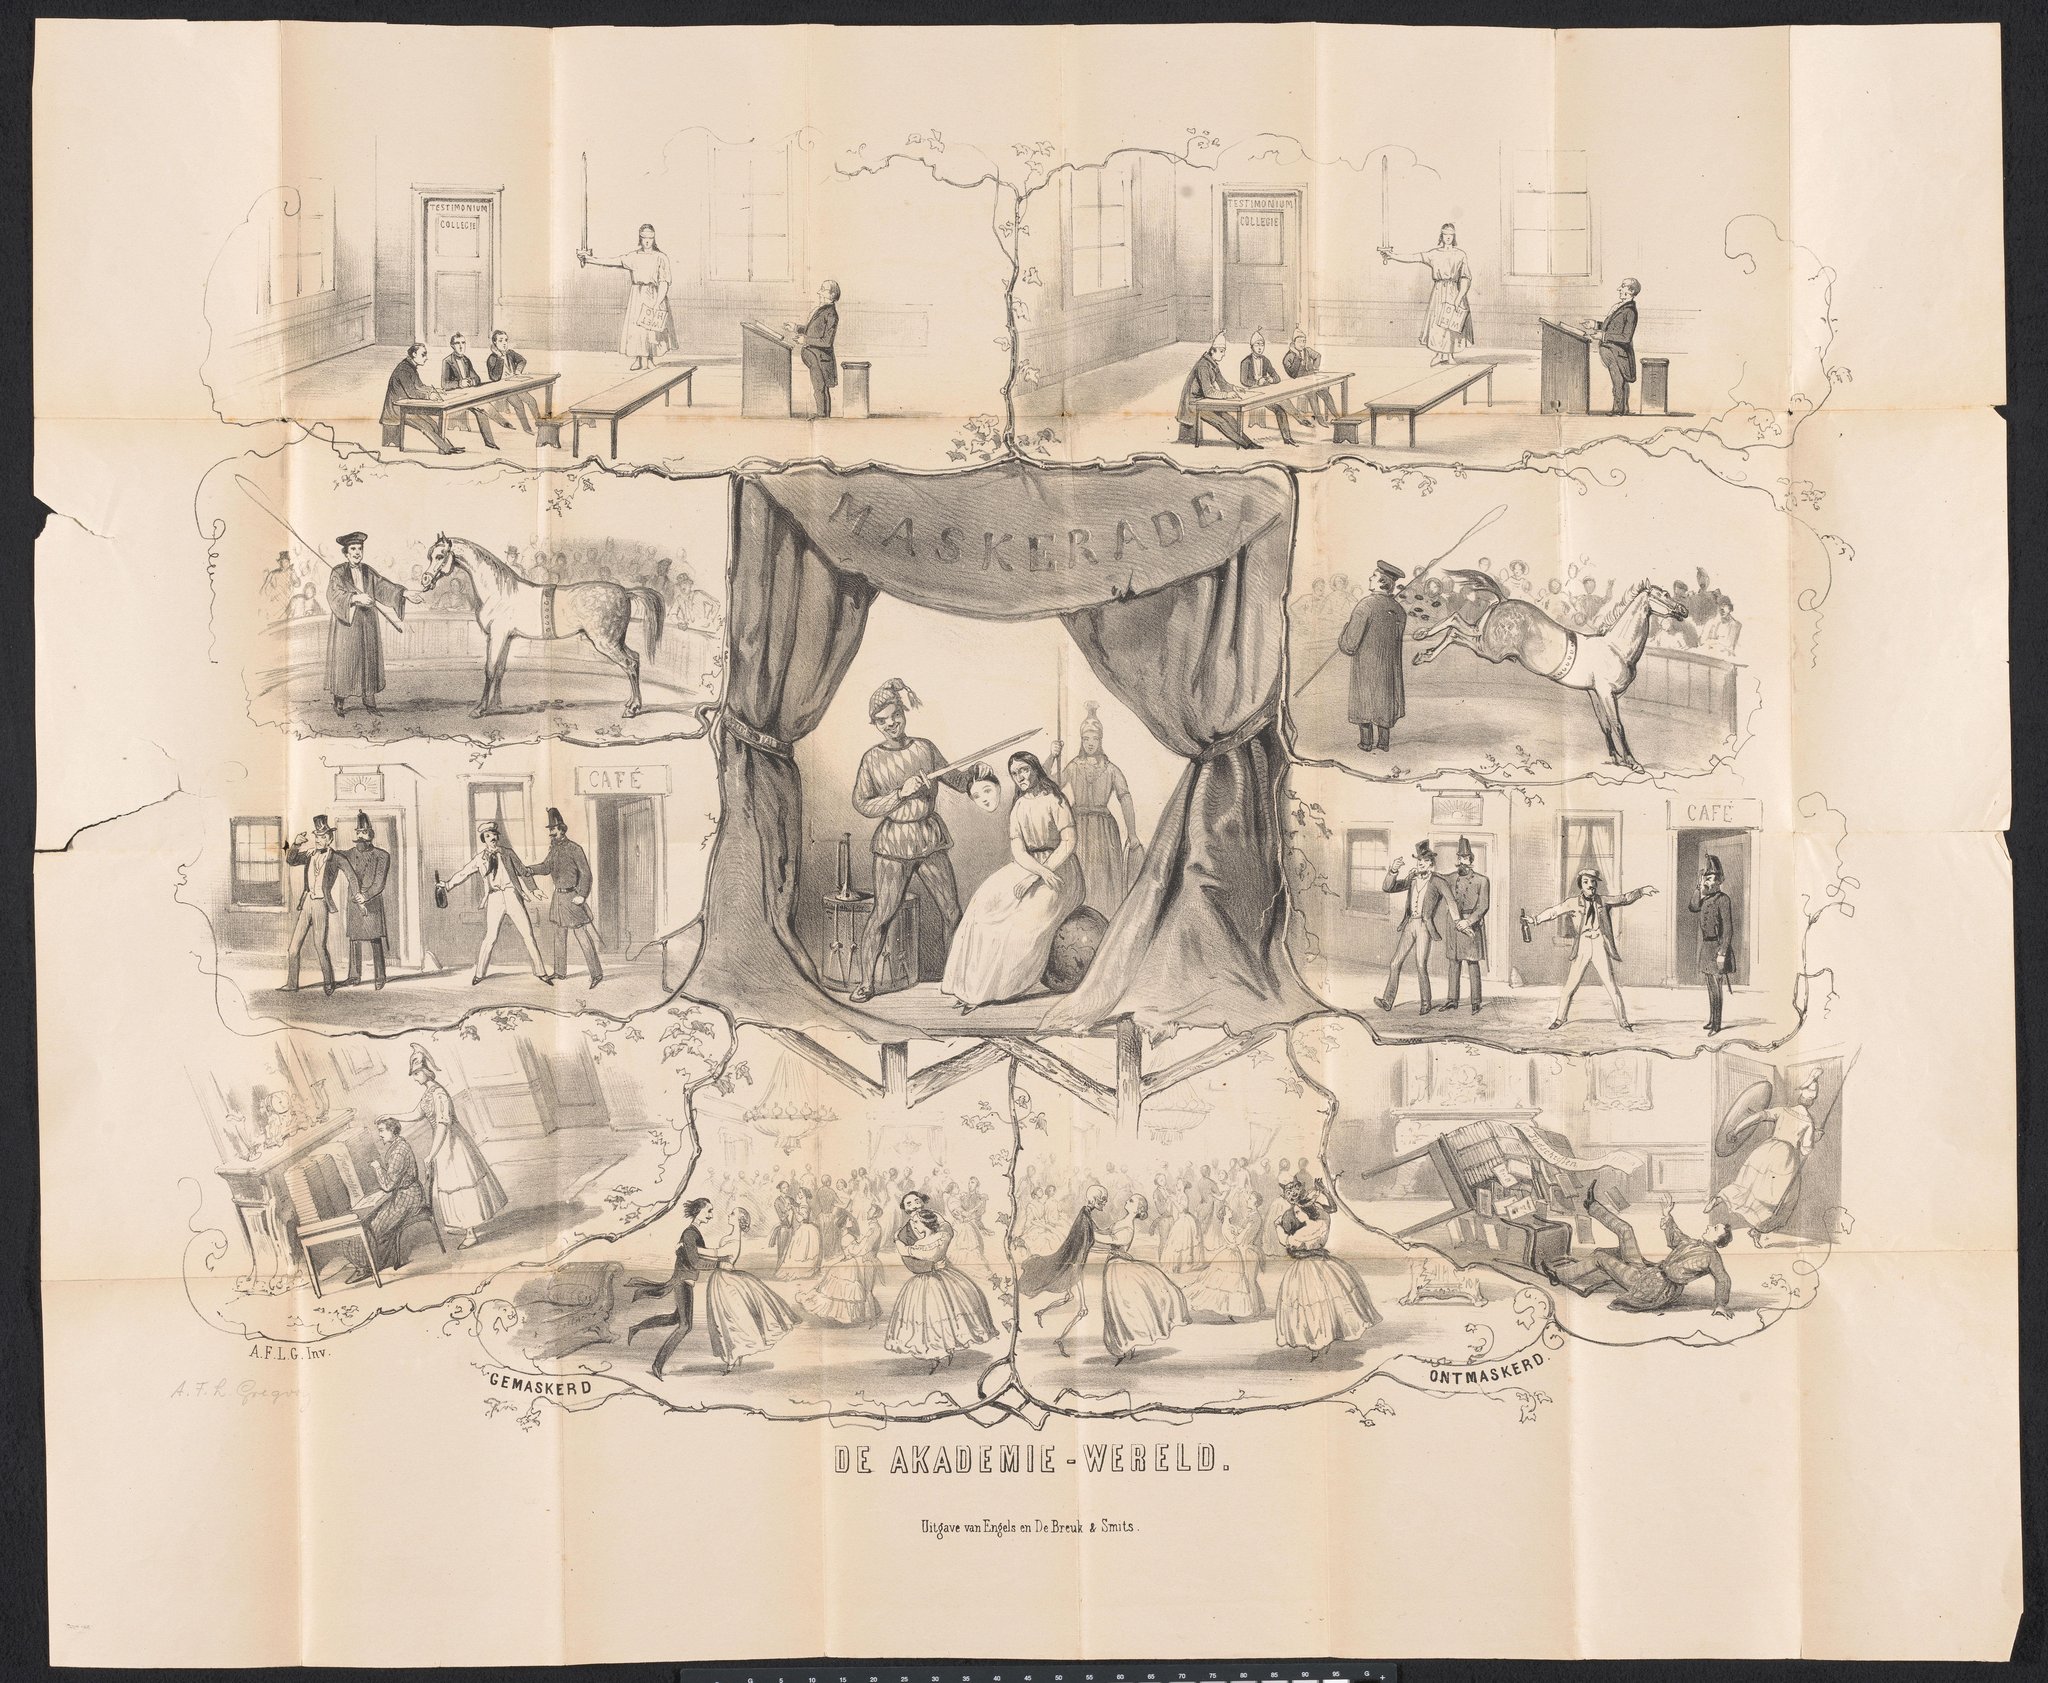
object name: cartoon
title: De Akademie-Wereld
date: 1862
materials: paper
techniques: lithograph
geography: netherlands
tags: student life, leiden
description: Blad met scènes en fantasieën uit het studentenleven, links 'gemaskerd'en rechts 'ontmaskerd'. Centraal een toneel 'Maskerade' waarop een harlekijn een oude vrouw een masker ontneemt. Deze prent los in een apart mapje voorin de almanak. Spotprent in de studentenalmanak van de Universiteit van Leiden van het jaar 1862.